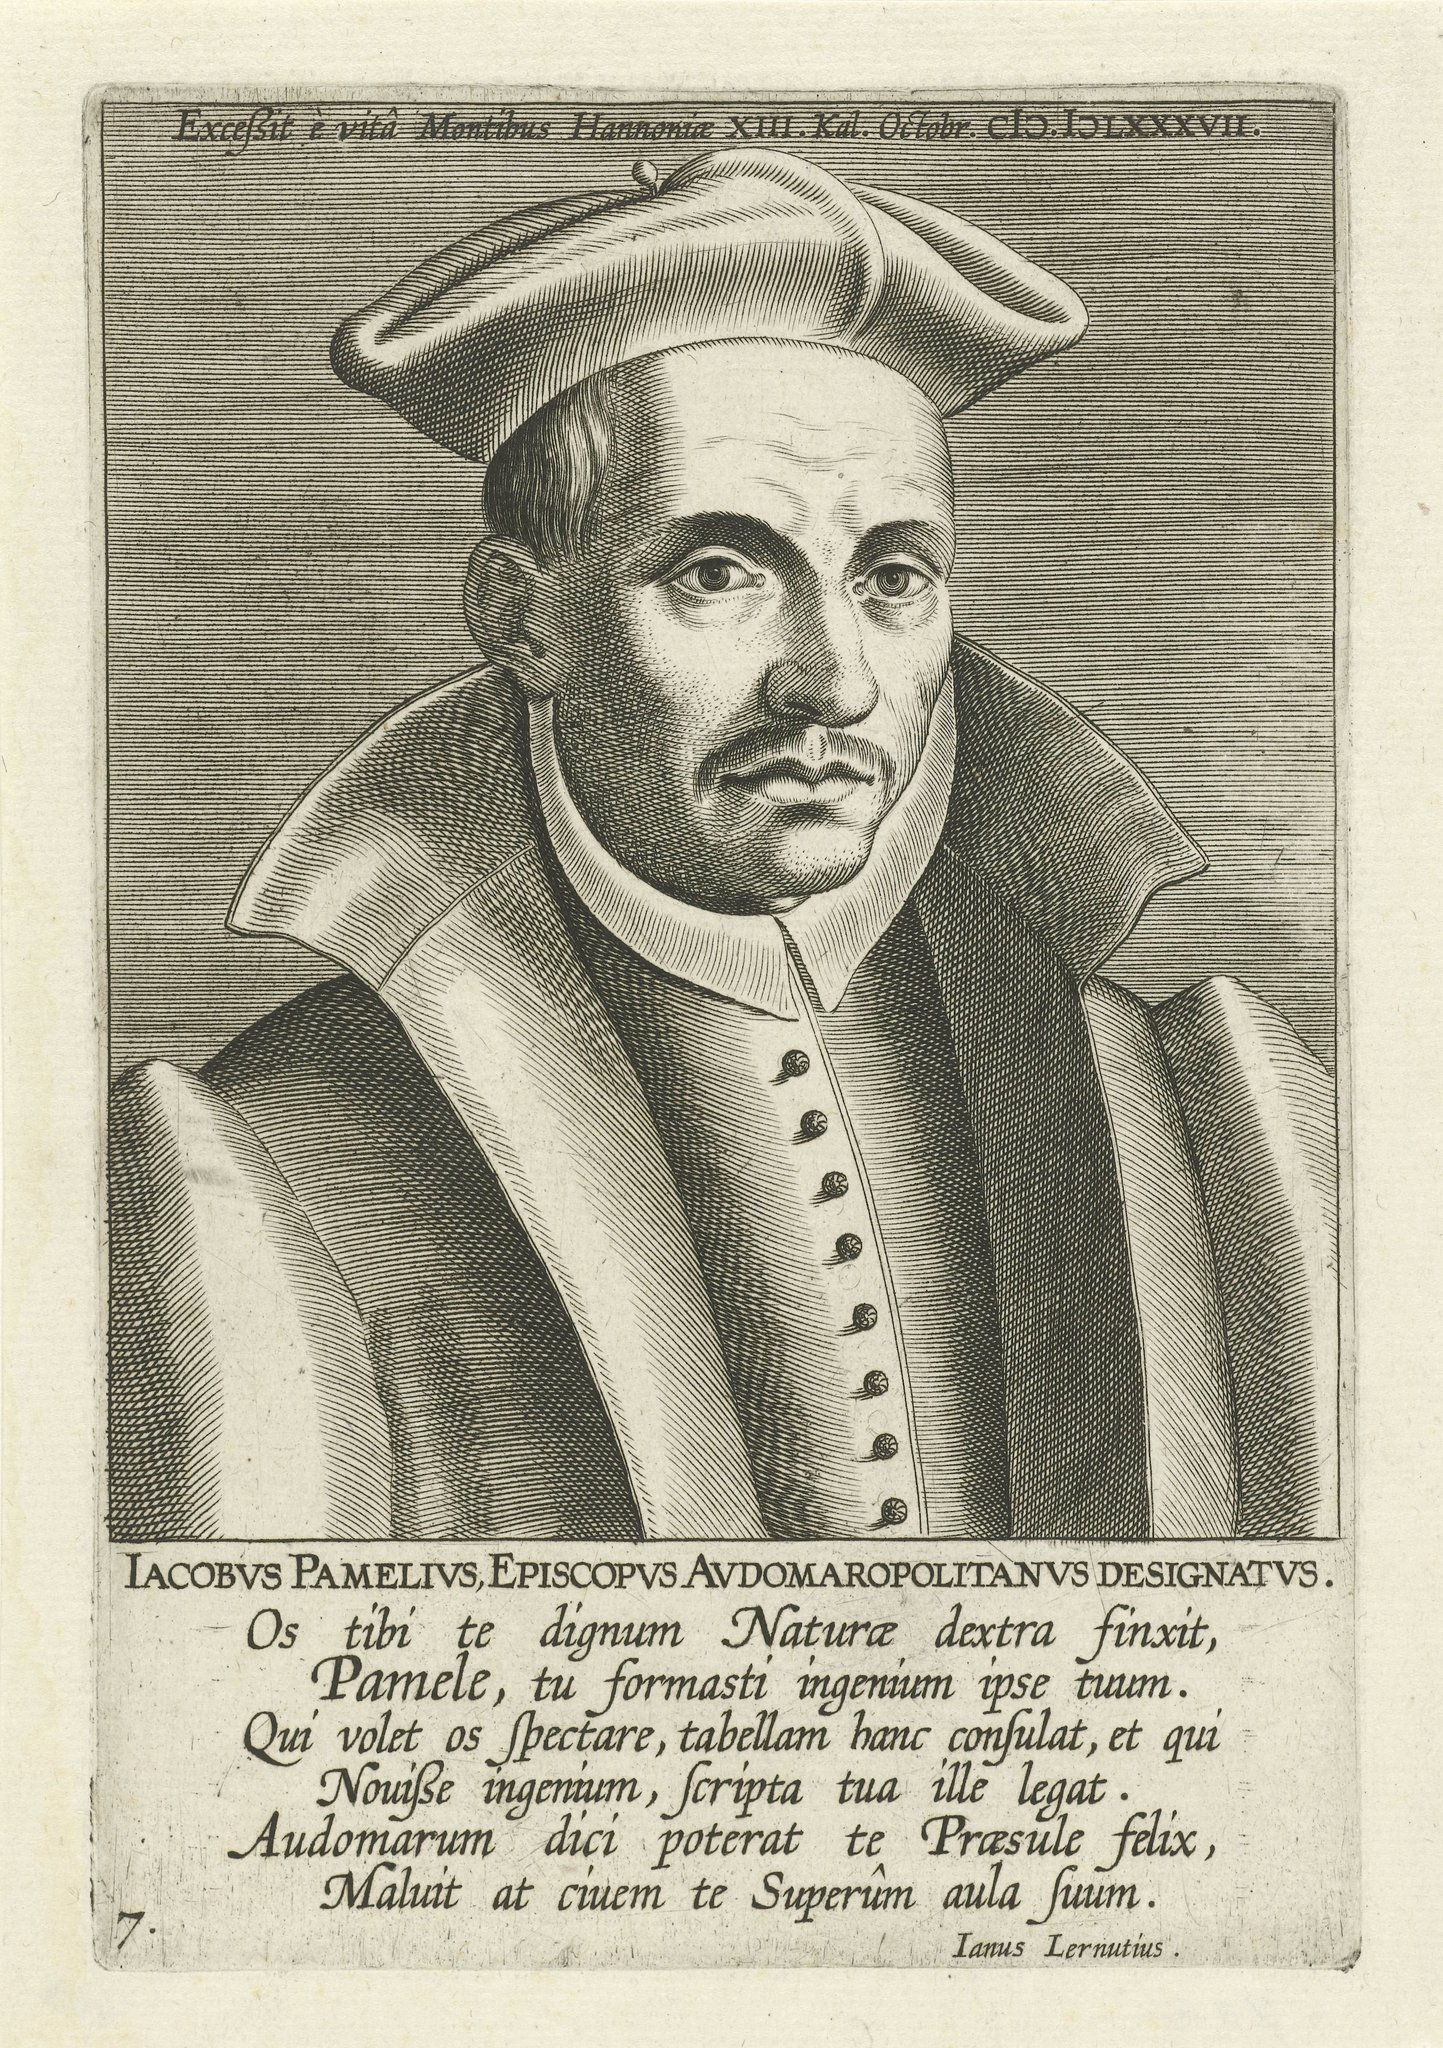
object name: print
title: Portretten van beroemde Nederlandse en Vlaamse geleerden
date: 1604-1608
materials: paper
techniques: engraving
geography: antwerp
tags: historical persons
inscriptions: collector's mark: Lugt 2228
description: Portret van Jacob van Pamele, Theoloog uit Brugge. Buste naar rechts. De prent heeft een Latijns boven- en onderschrift en maakt deel uit van een serie van beroemde Nederlandse en Vlaamse geleerden.